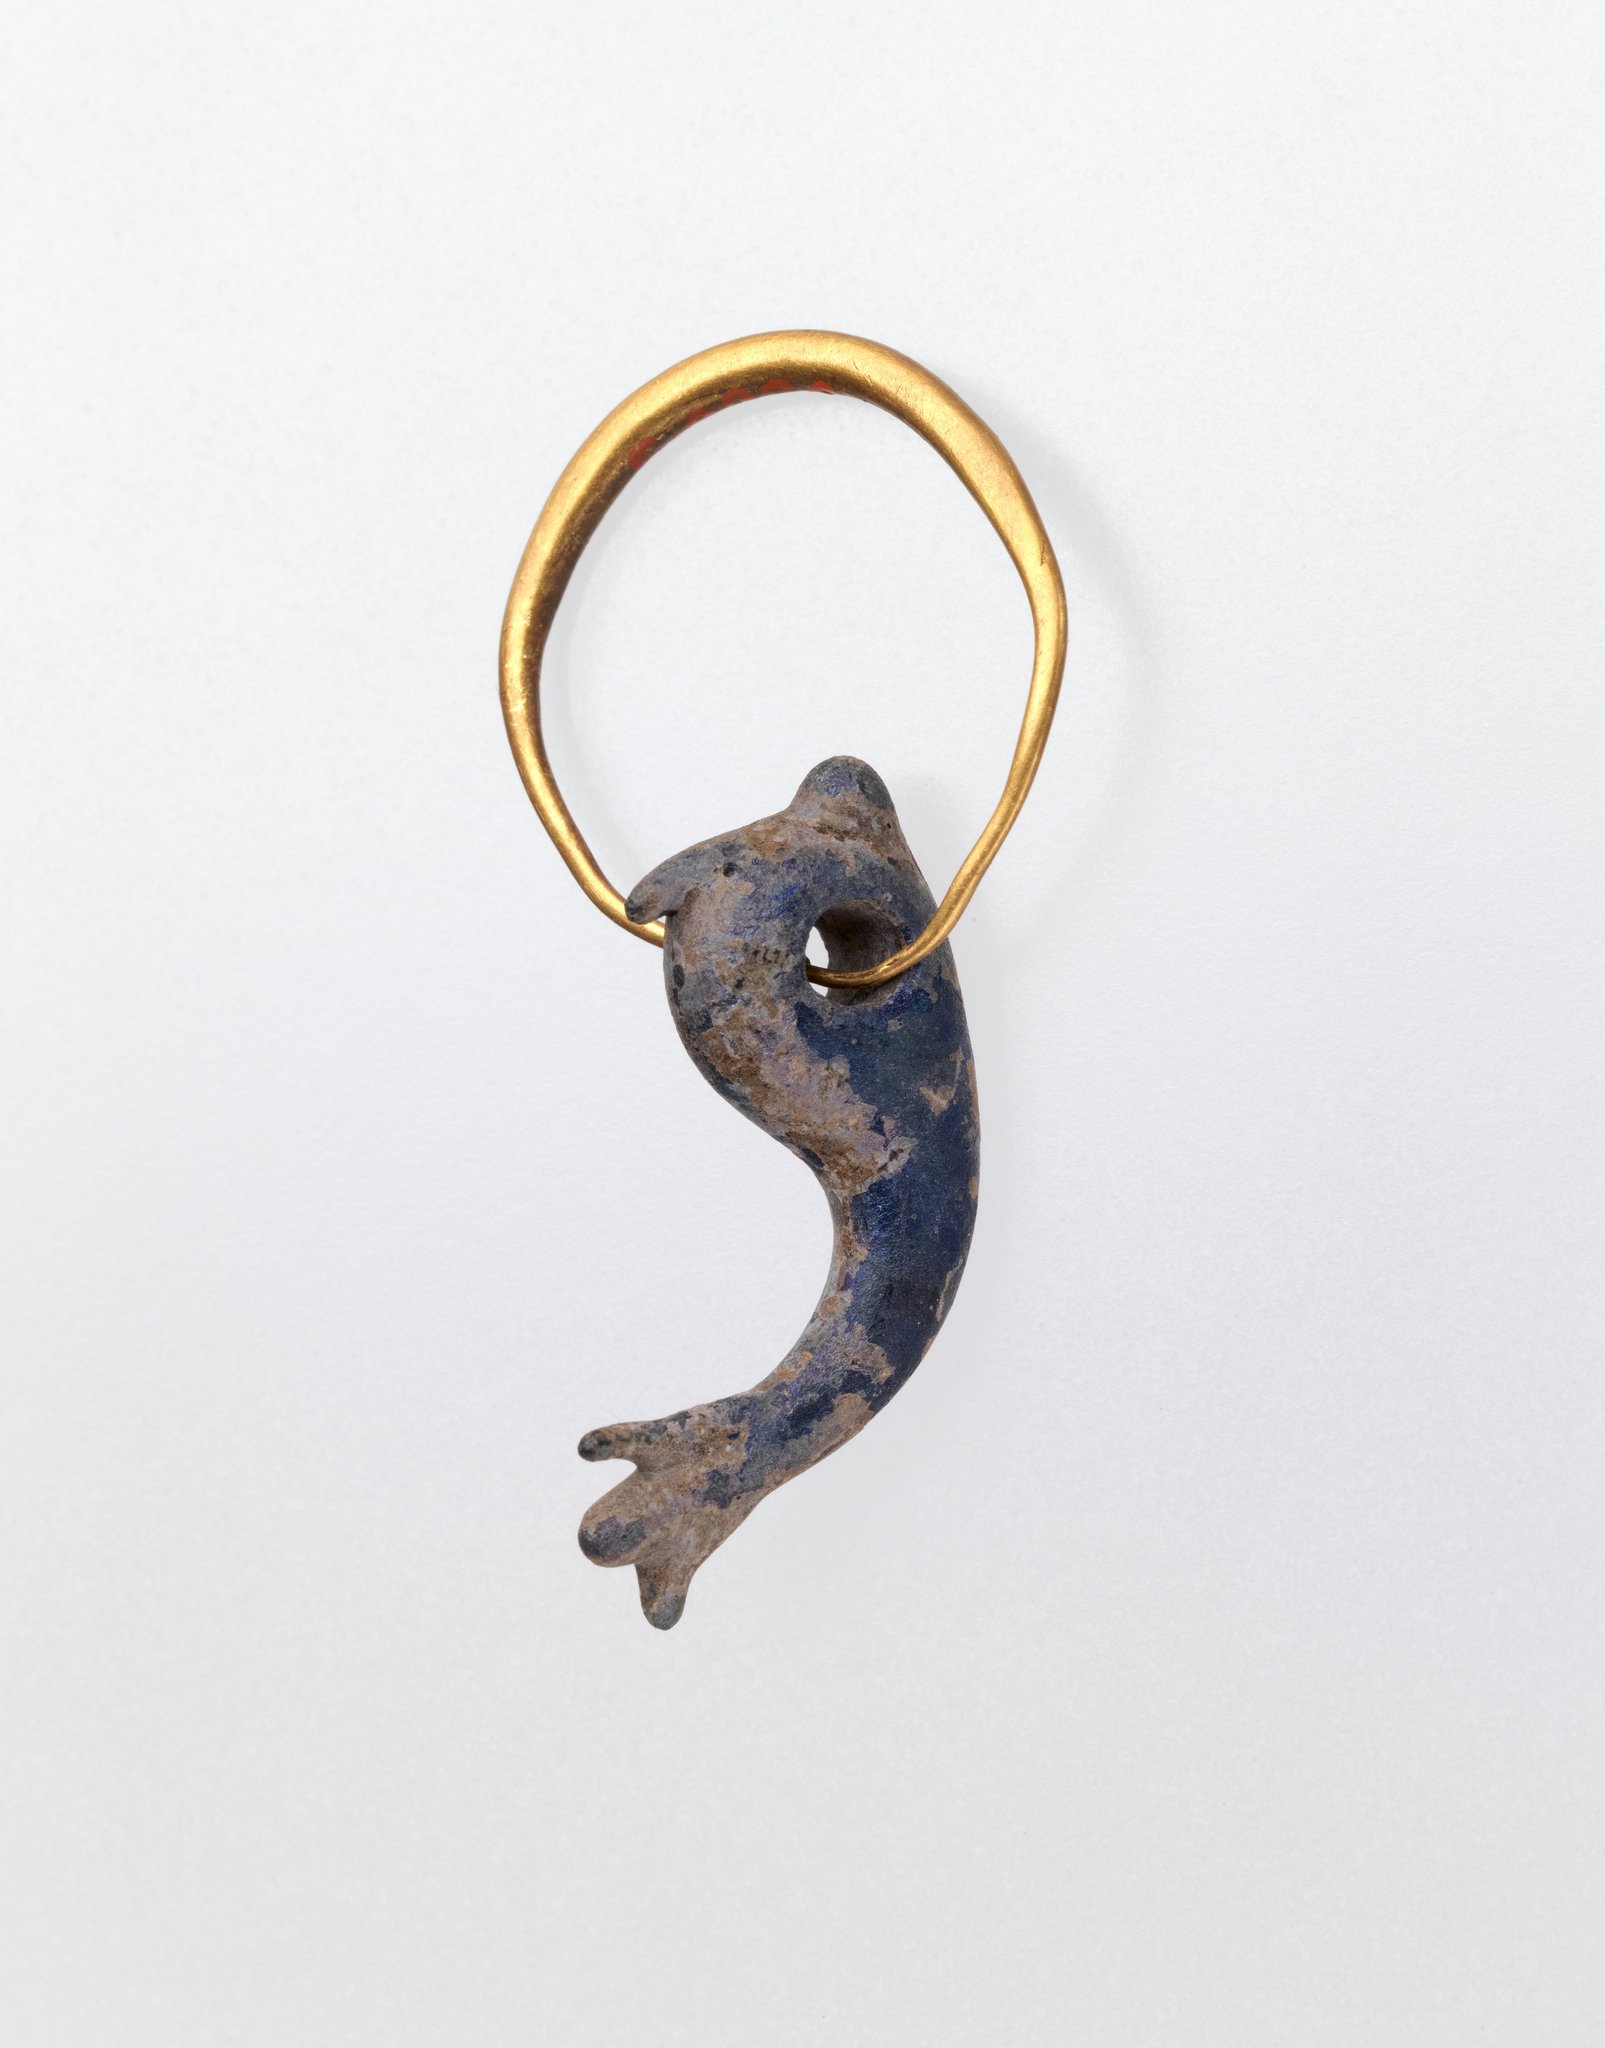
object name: dolphin pendant on gold wire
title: Gold earring with glass pendant in the form of a dolphin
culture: roman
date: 201-500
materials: glass, gold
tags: dolphins